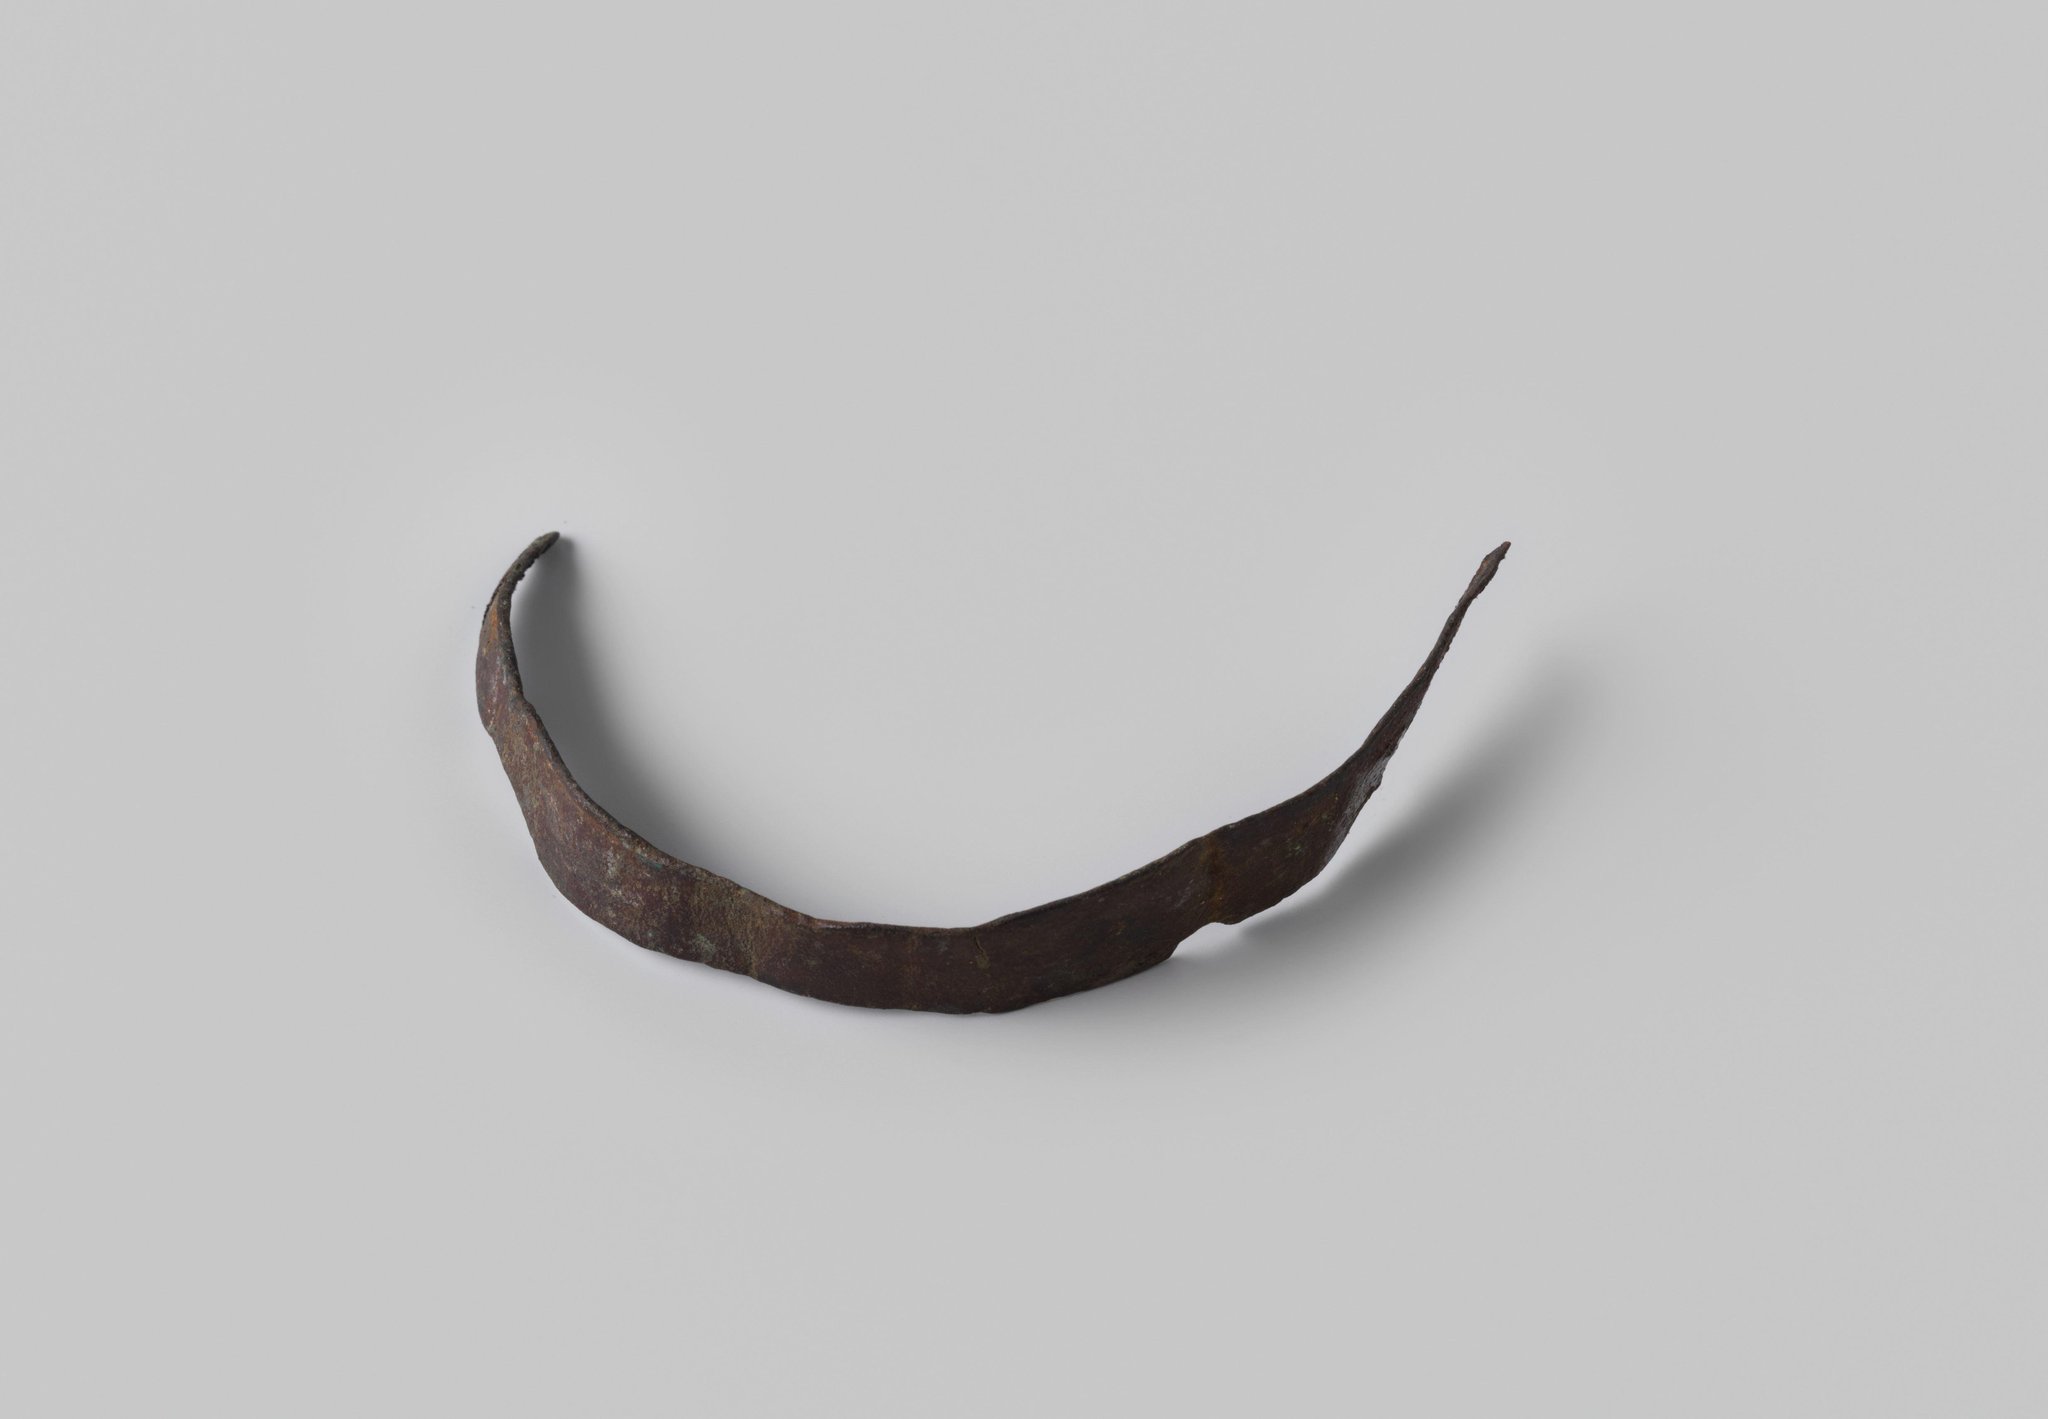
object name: fragment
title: Fragment van koper uit het wrak van de Oost-Indiëvaarder Hollandia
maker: Anonymous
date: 1700-1743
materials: copper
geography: netherlands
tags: verenigde oostindische compagnie, hollandia (schip), annet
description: Varied parts or fragments, strips and strip-shaped fragments; fragm.